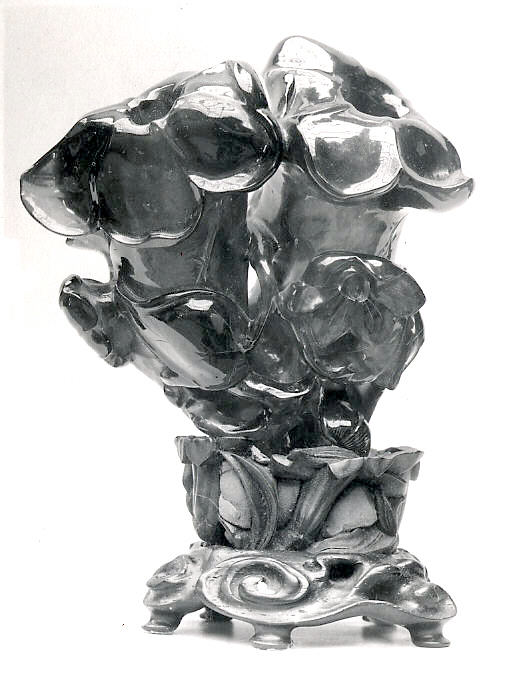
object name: double vase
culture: chinese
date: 1736-1795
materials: amber